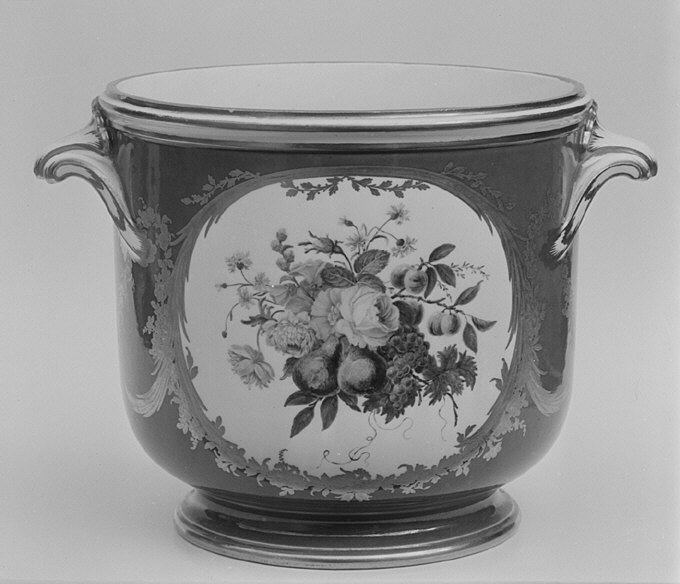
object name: bottle cooler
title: Bottle cooler (seau à bouteille) (part of a service)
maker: sèvres manufactory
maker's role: manufactory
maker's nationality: french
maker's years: 1740-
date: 1783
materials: soft paste porcelain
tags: fruit,flowers